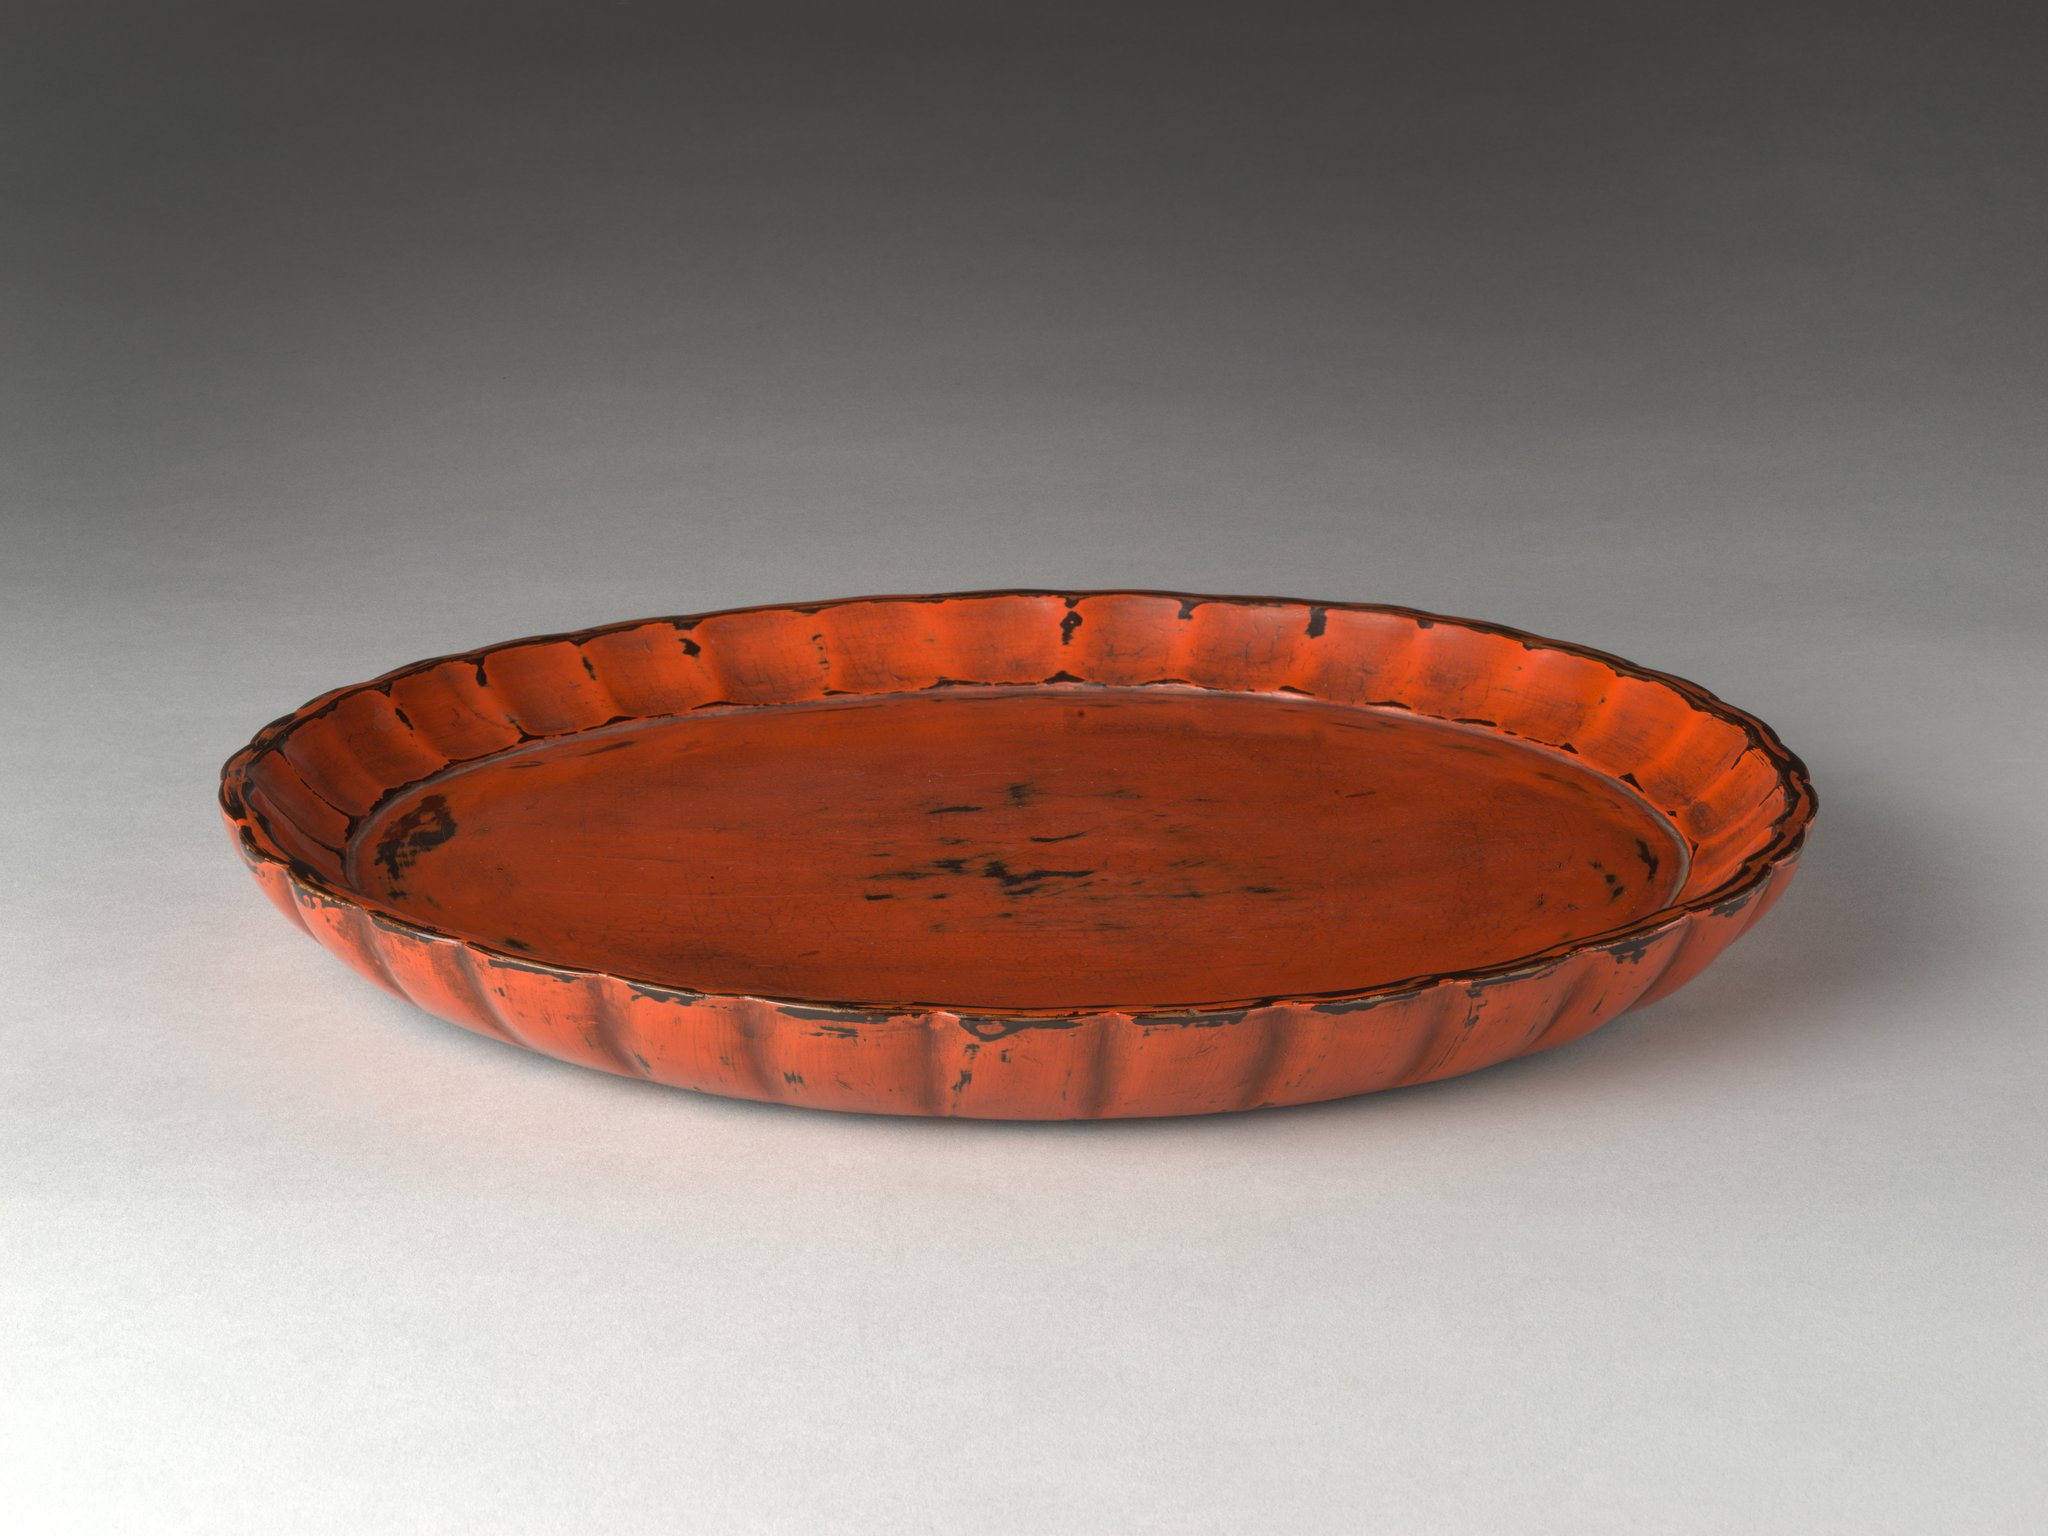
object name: tray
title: Lobed Tray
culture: japanese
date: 1401-1600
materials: lacquer, wood